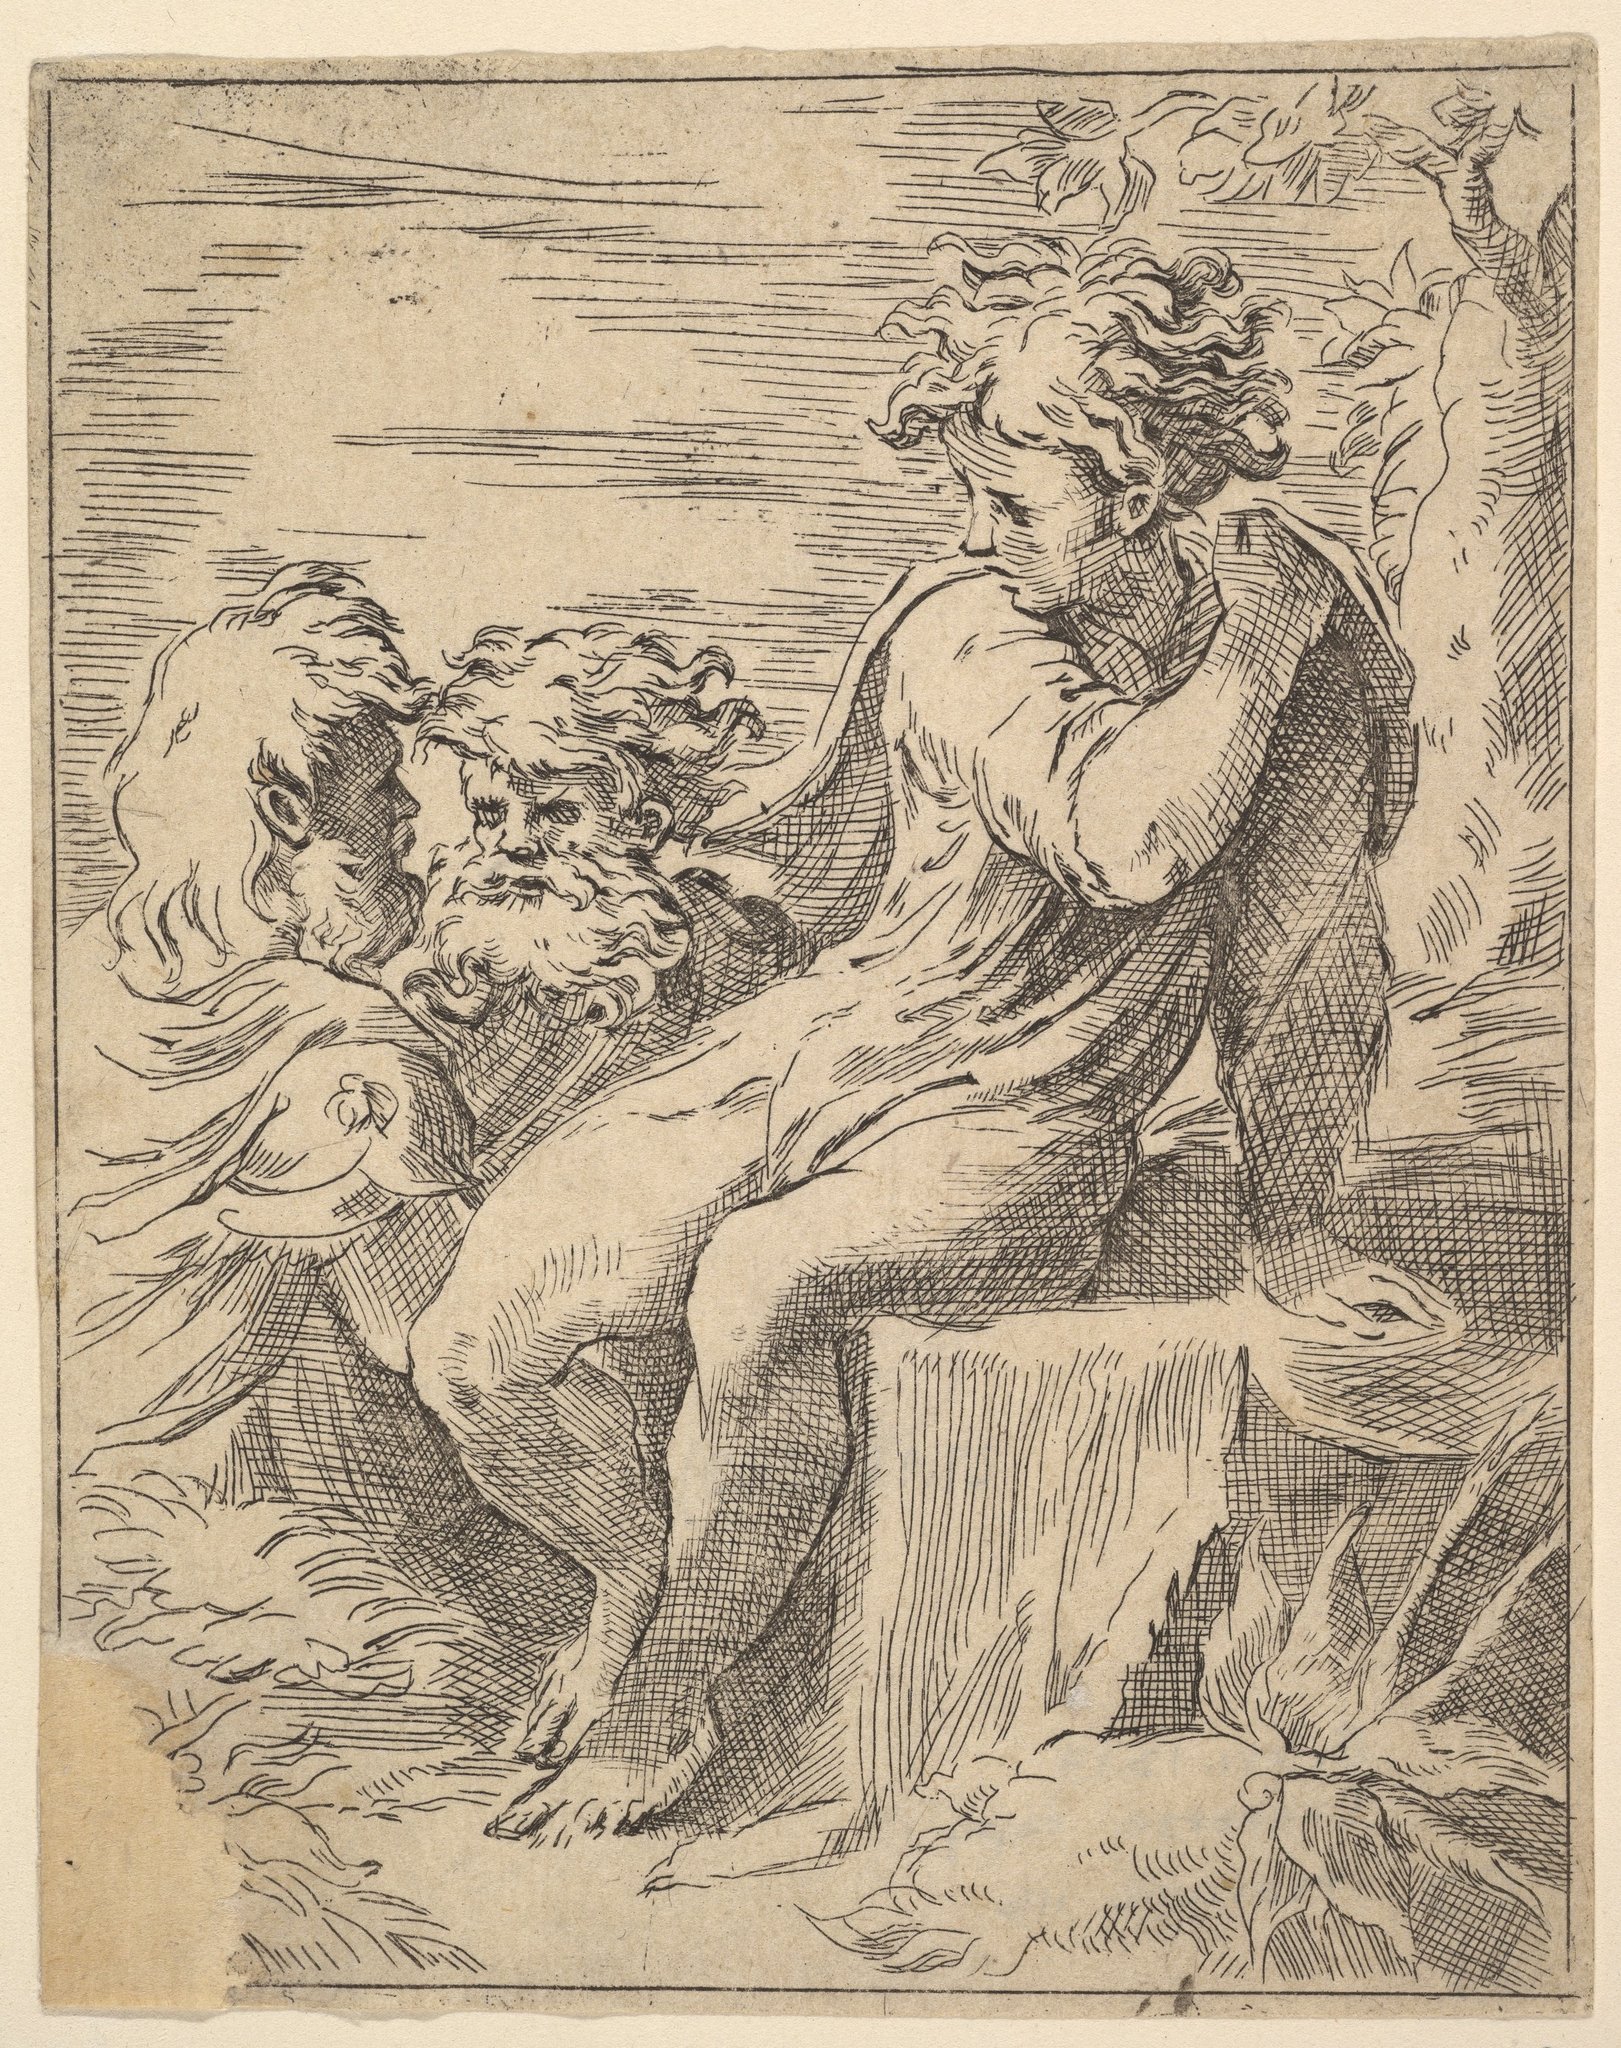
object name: print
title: Youth with two Old Men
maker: anonymous, italian, 17th century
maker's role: artist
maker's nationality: italian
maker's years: 1600-1700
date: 1601-1700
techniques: etching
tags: boys,men